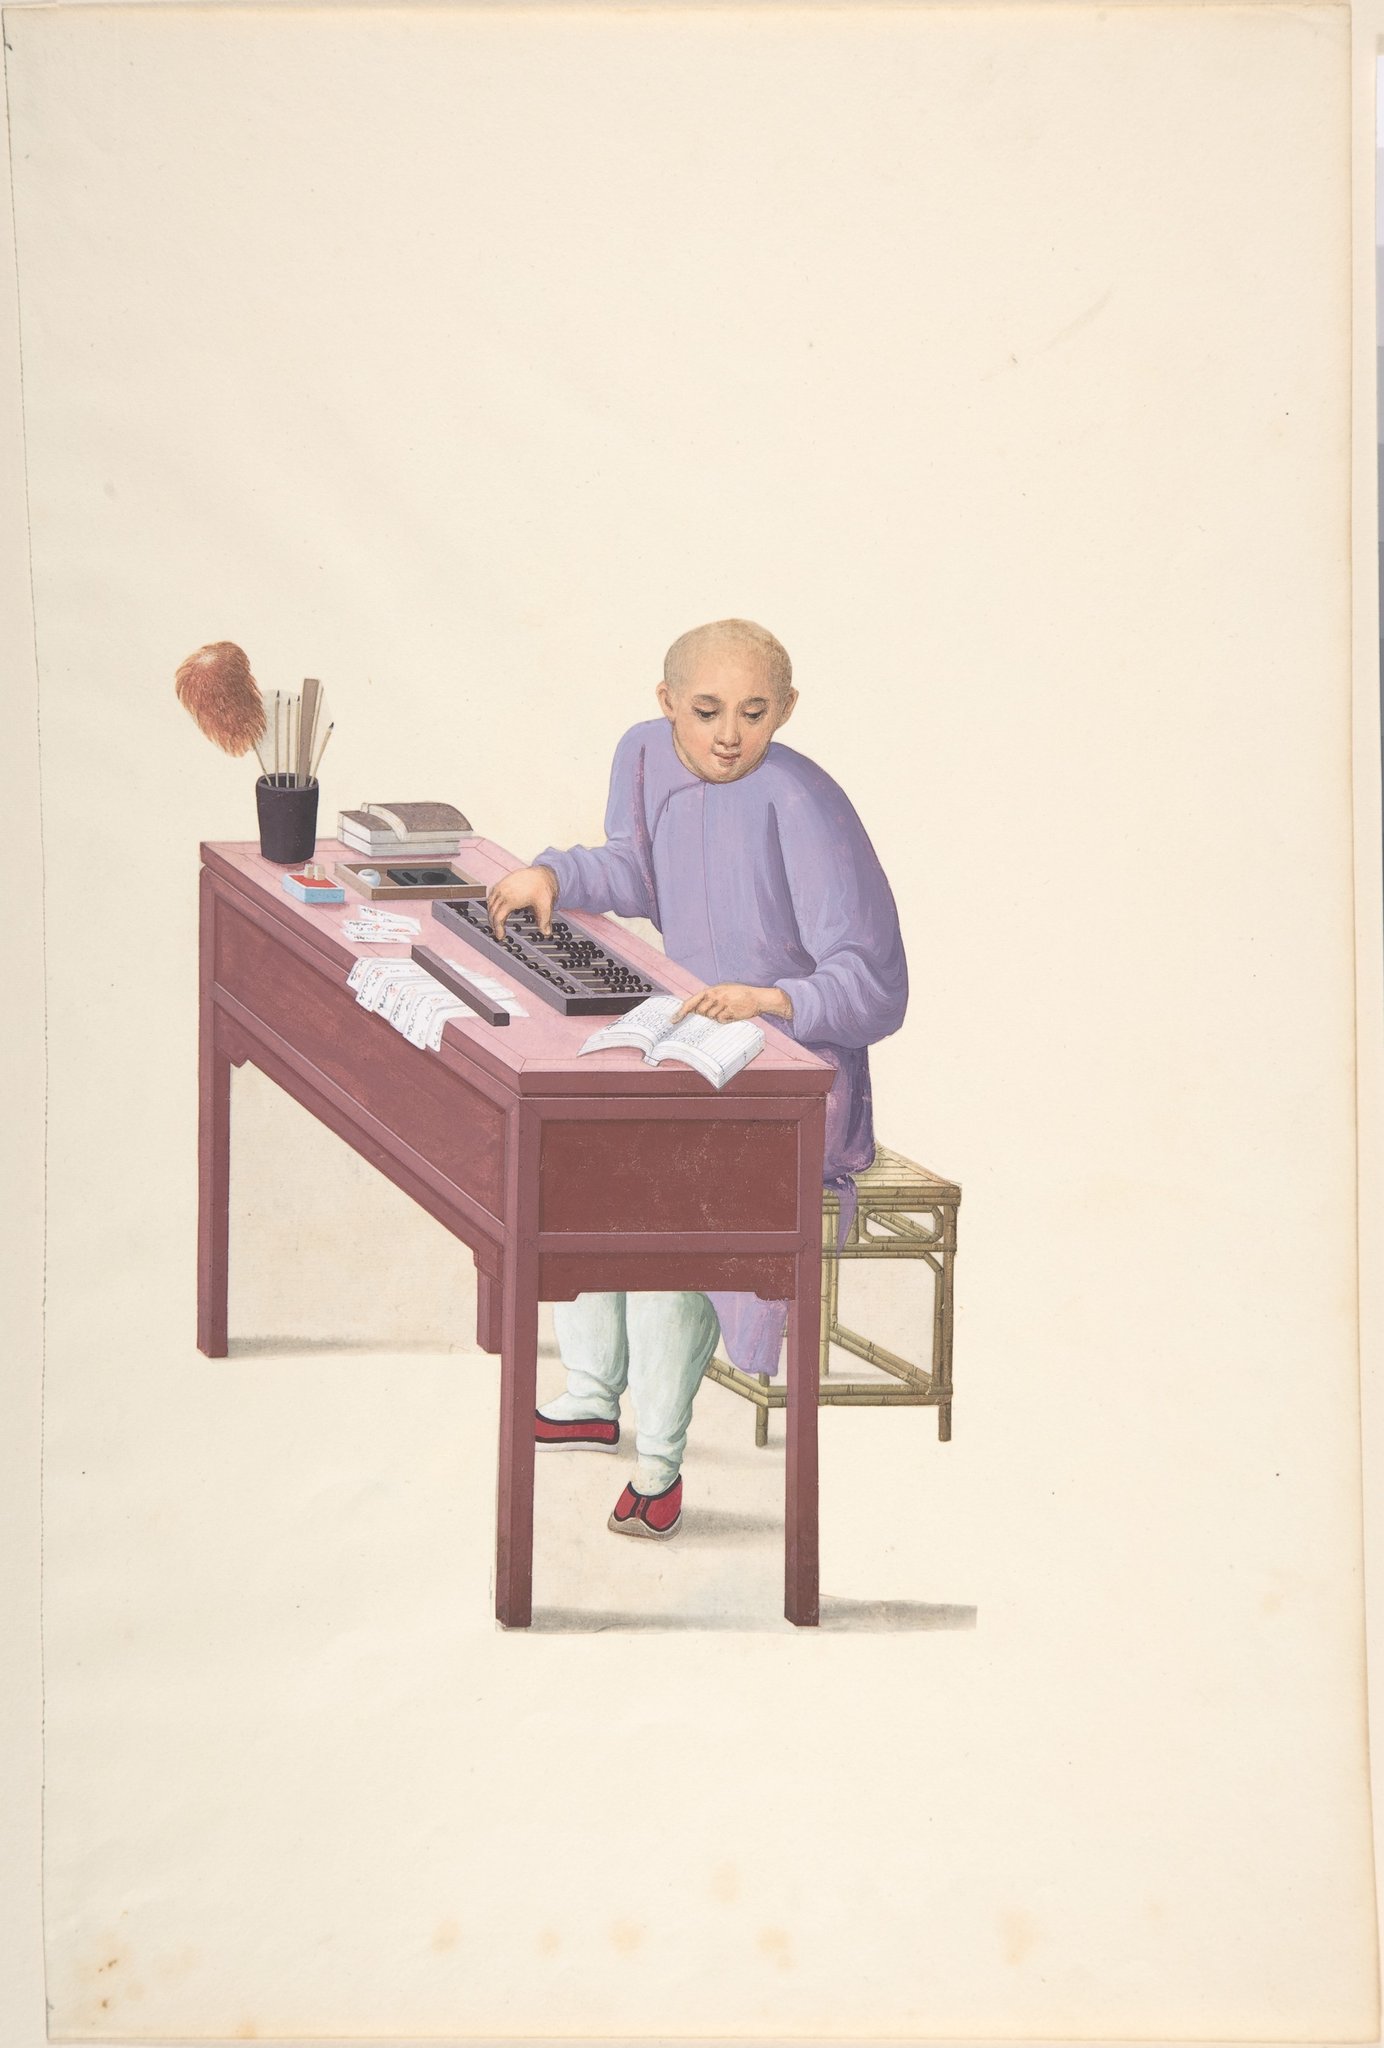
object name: drawing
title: Chinese Man at Desk with an Abbacus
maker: anonymous, chinese, 19th century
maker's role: artist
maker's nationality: chinese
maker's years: 1800-1900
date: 1801-1900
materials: gouache, watercolor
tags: men,desks